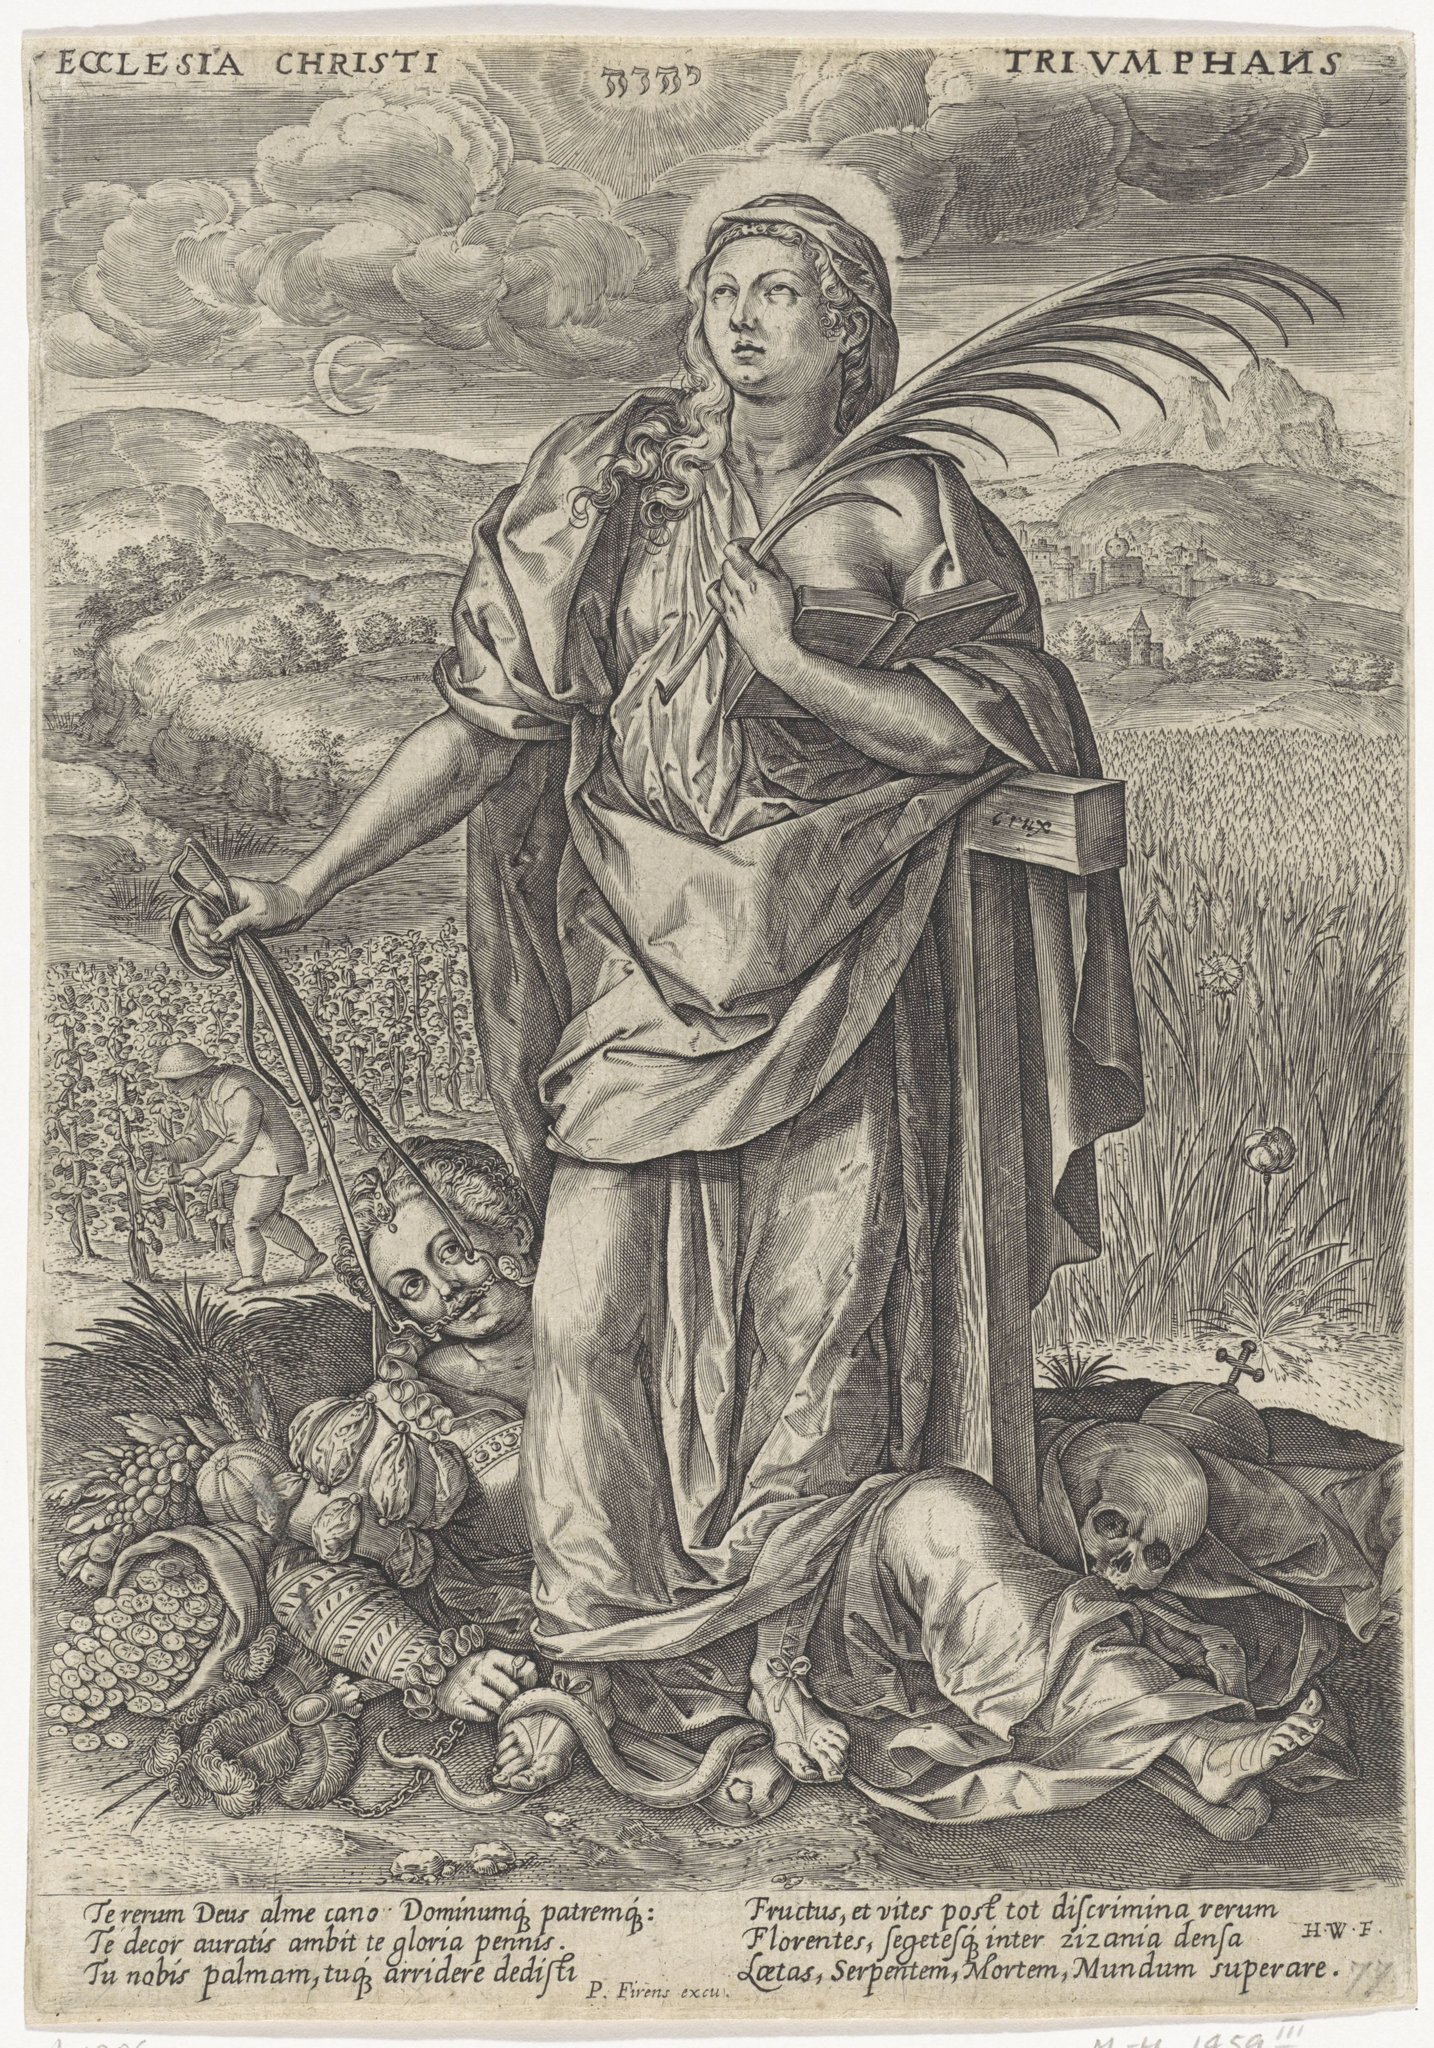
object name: print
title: Ecclesia Christi Trivmphans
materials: paper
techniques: engraving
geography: paris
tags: vineyard, triumph of the church (or religion), ear of corn, tetragram (in roman or hebrew script) ~ symbol of god the father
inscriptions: collector's mark: Lugt 2228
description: Landschap met het Geloof, achter haar het kruis. Ze houdt een palmtak in de ene hand, in de andere hand de teugels van het bit waarmee ze de Ketterij bedwingt. Ketterij wordt vertrapt door Geloof. Ze spartelt op de grond, te midden van wereldse symbolen. Links op de achtergrond is een man druiven aan het plukken op een akker met wijnranken. Rechts op de achtergrond een akker met korenaren. Boven in de lucht een tetragram, symbool van God de Vader. In de marge een zesregelig onderschrift, in twee kolommen, in het Latijn.